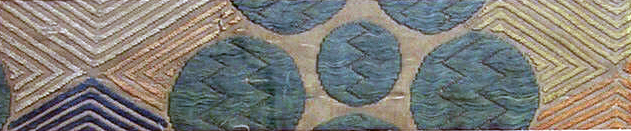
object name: piece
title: Textile with Partial Pattern of Star Discs on a Background of Concentric Diamond Lozenges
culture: japanese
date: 1615-1868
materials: silk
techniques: brocade, weave